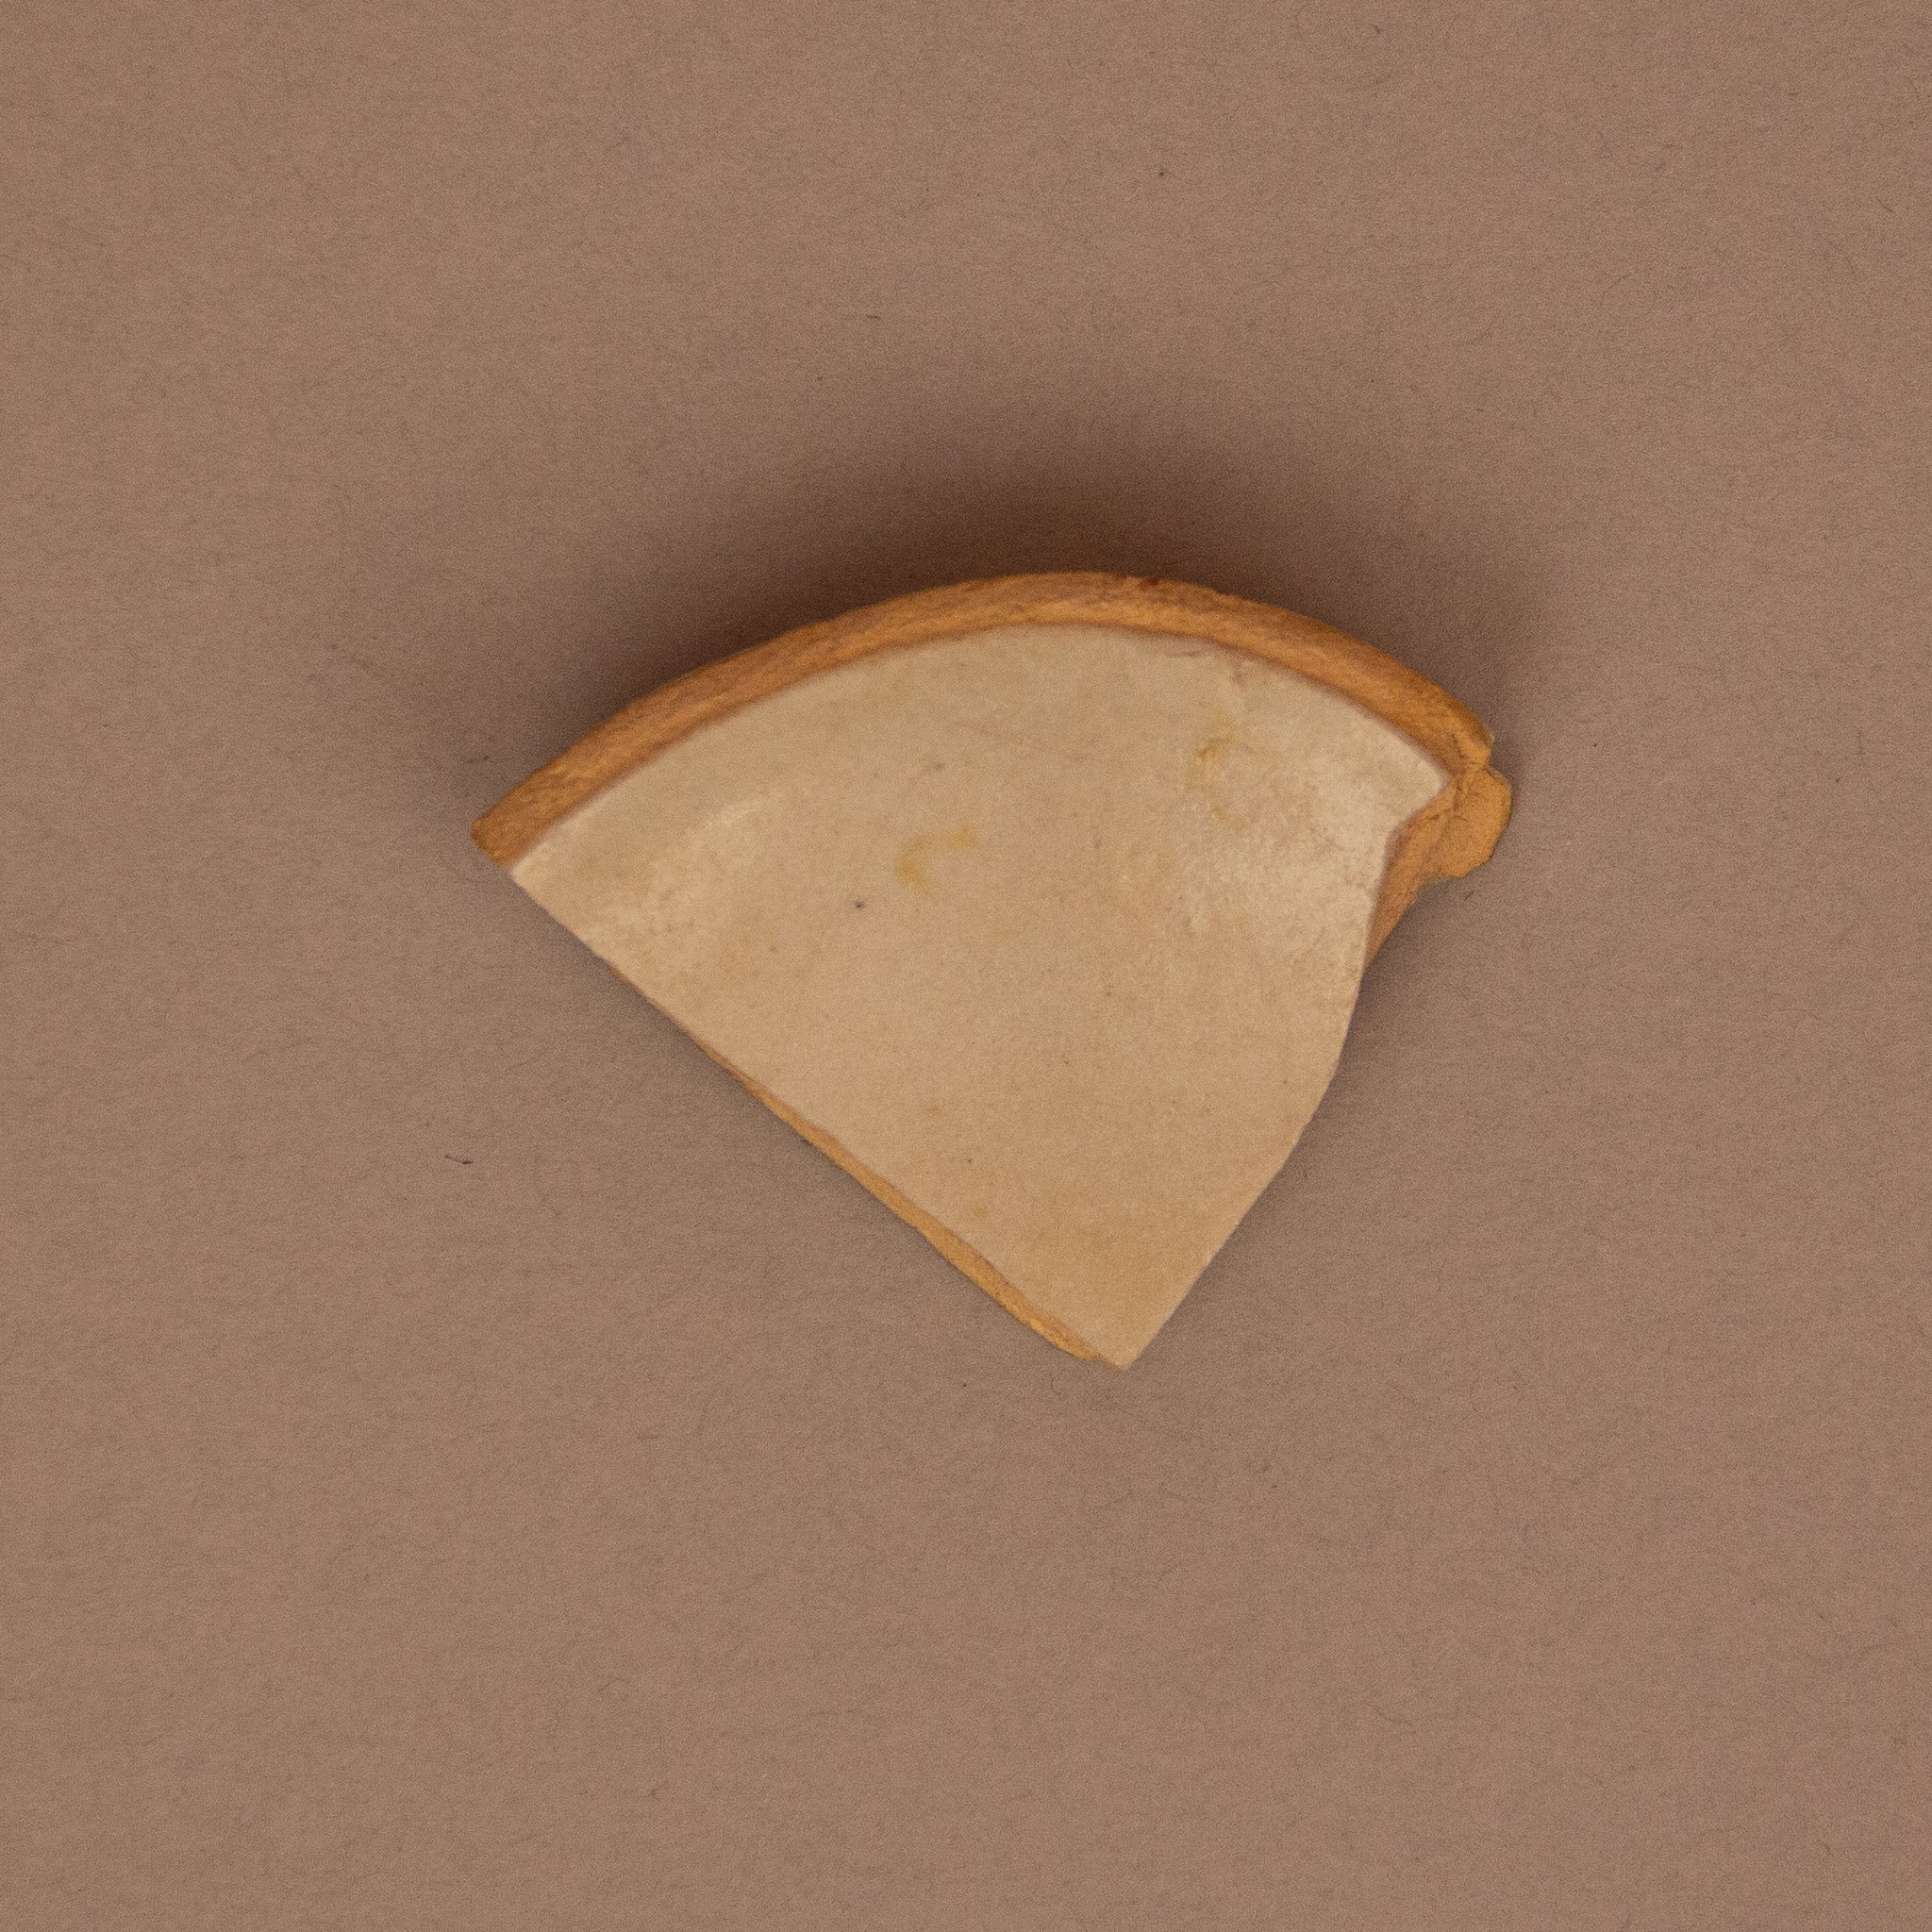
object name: fragment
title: Fragments of Ceramics with Opacified Glaze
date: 801-900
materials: earthenware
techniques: glazing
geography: iraq